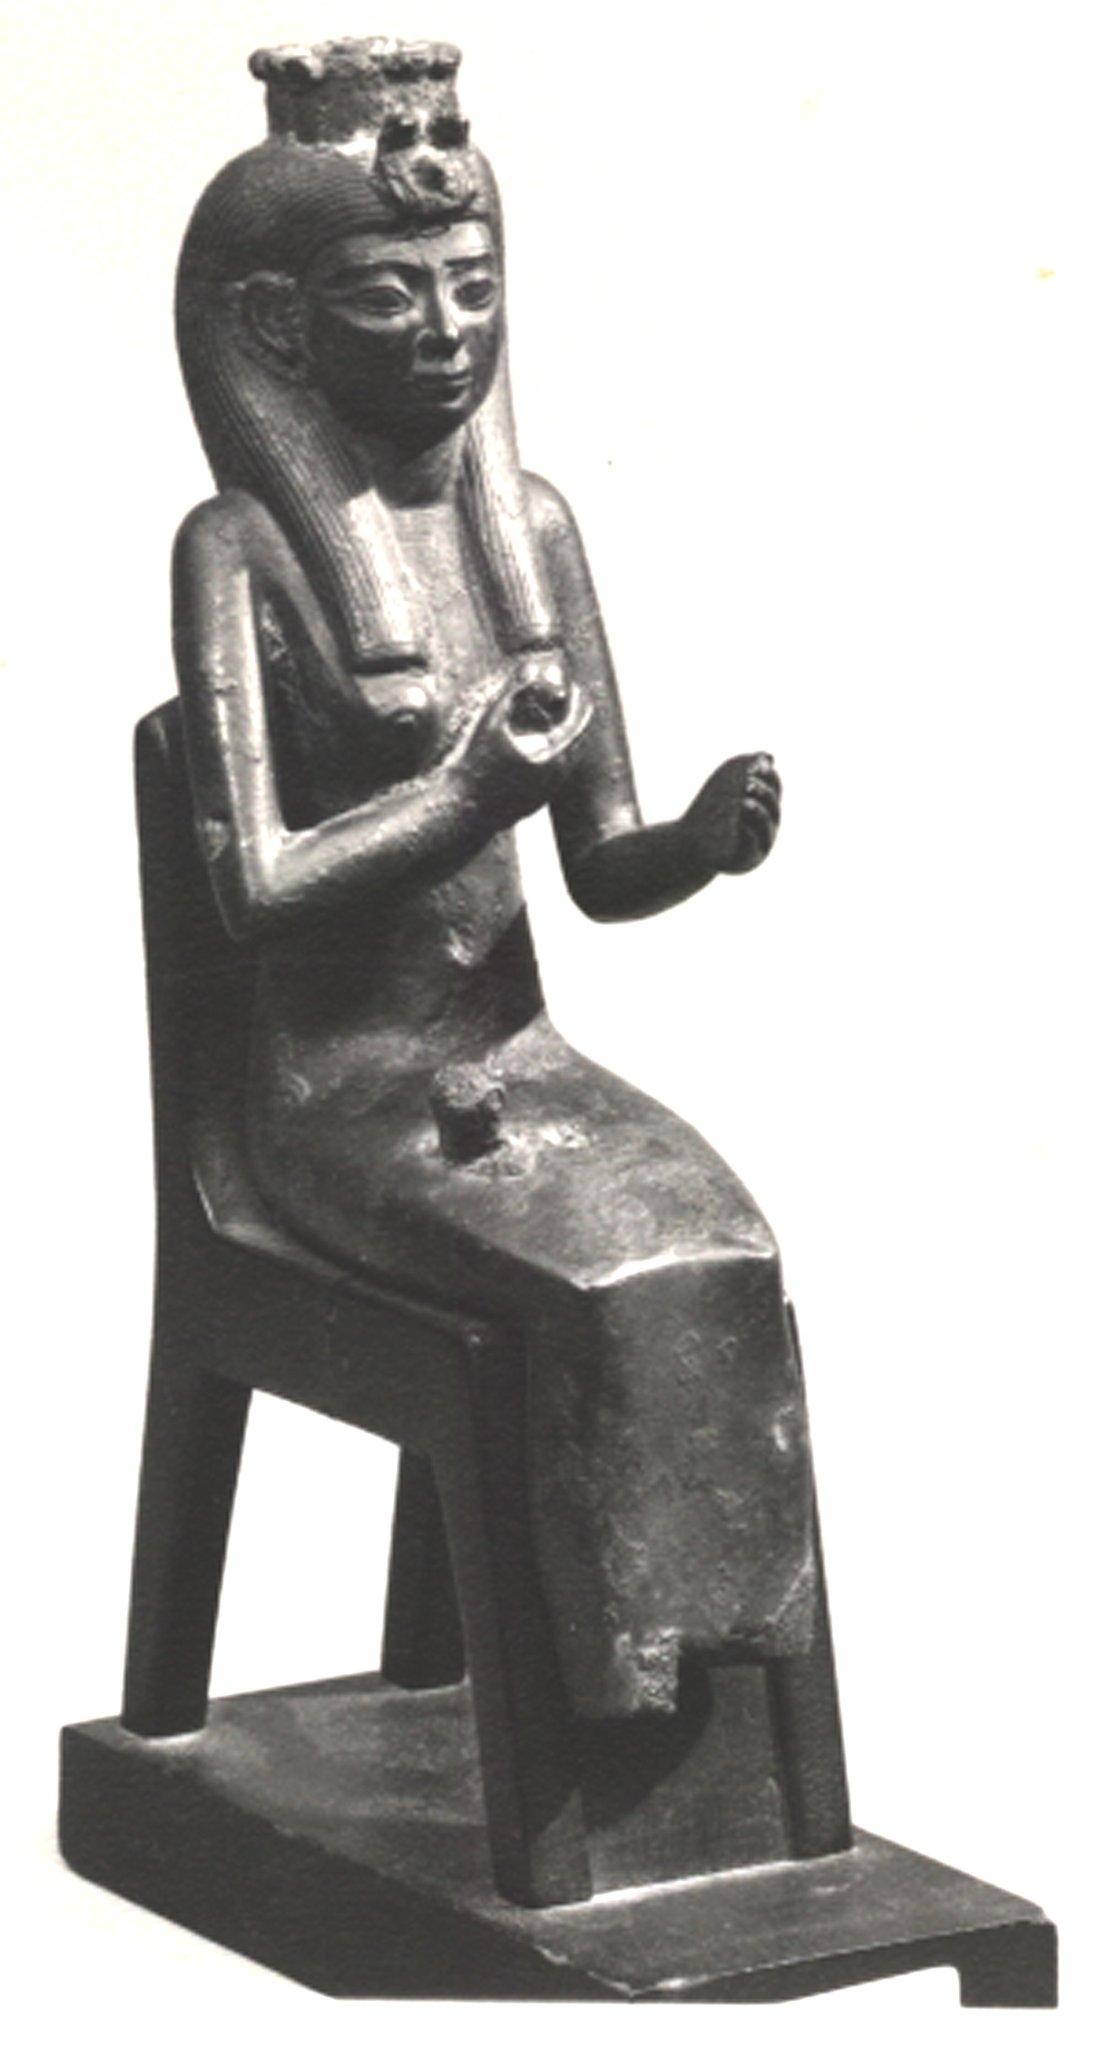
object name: statuette, isi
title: Statuette of Isis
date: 712-343 BCE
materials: bronze, copper alloy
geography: egypt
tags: isis